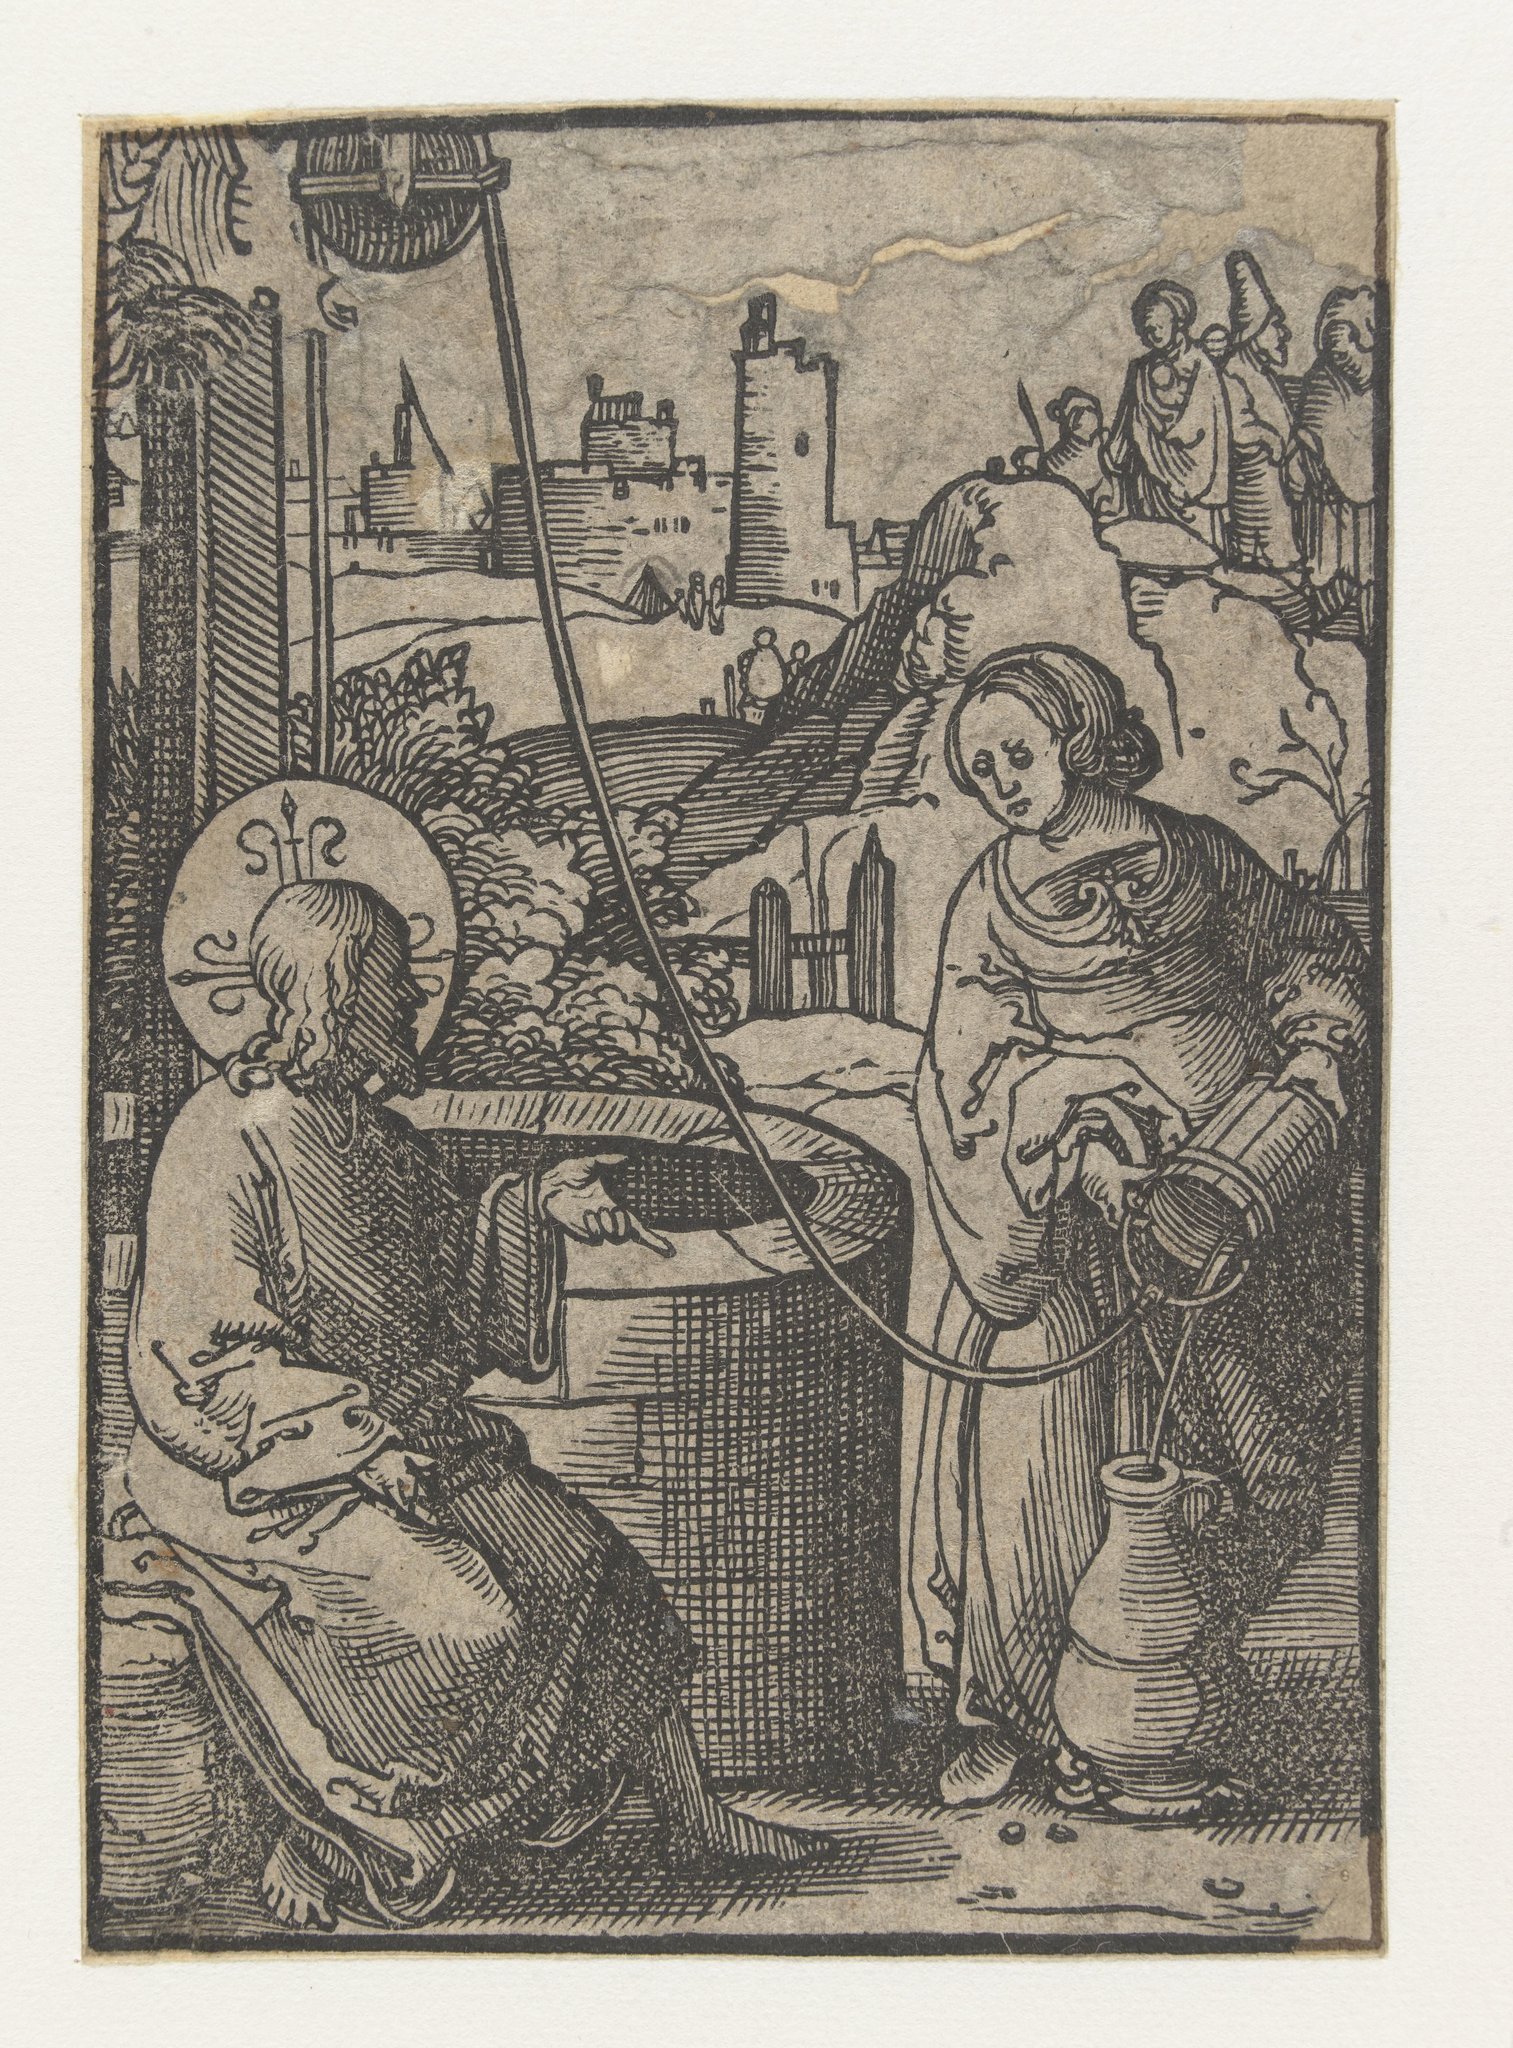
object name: book illustration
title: Stomme Passie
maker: Anonymous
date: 1518-1522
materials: paper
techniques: pen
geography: low countries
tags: christ and the woman of samaria: sitting at jacob's well he asks her for a drink from her jug, book in which illustrations are essential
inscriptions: collector's mark: Lugt 2228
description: Houtsnede gebruikt als illustratie in "Hier begint een scoone stomme passye ... tot LXXX fighuren toe", uitgegeven door Doen Pietersz. te Amsterdam, waarschijnlijk ná 1526.